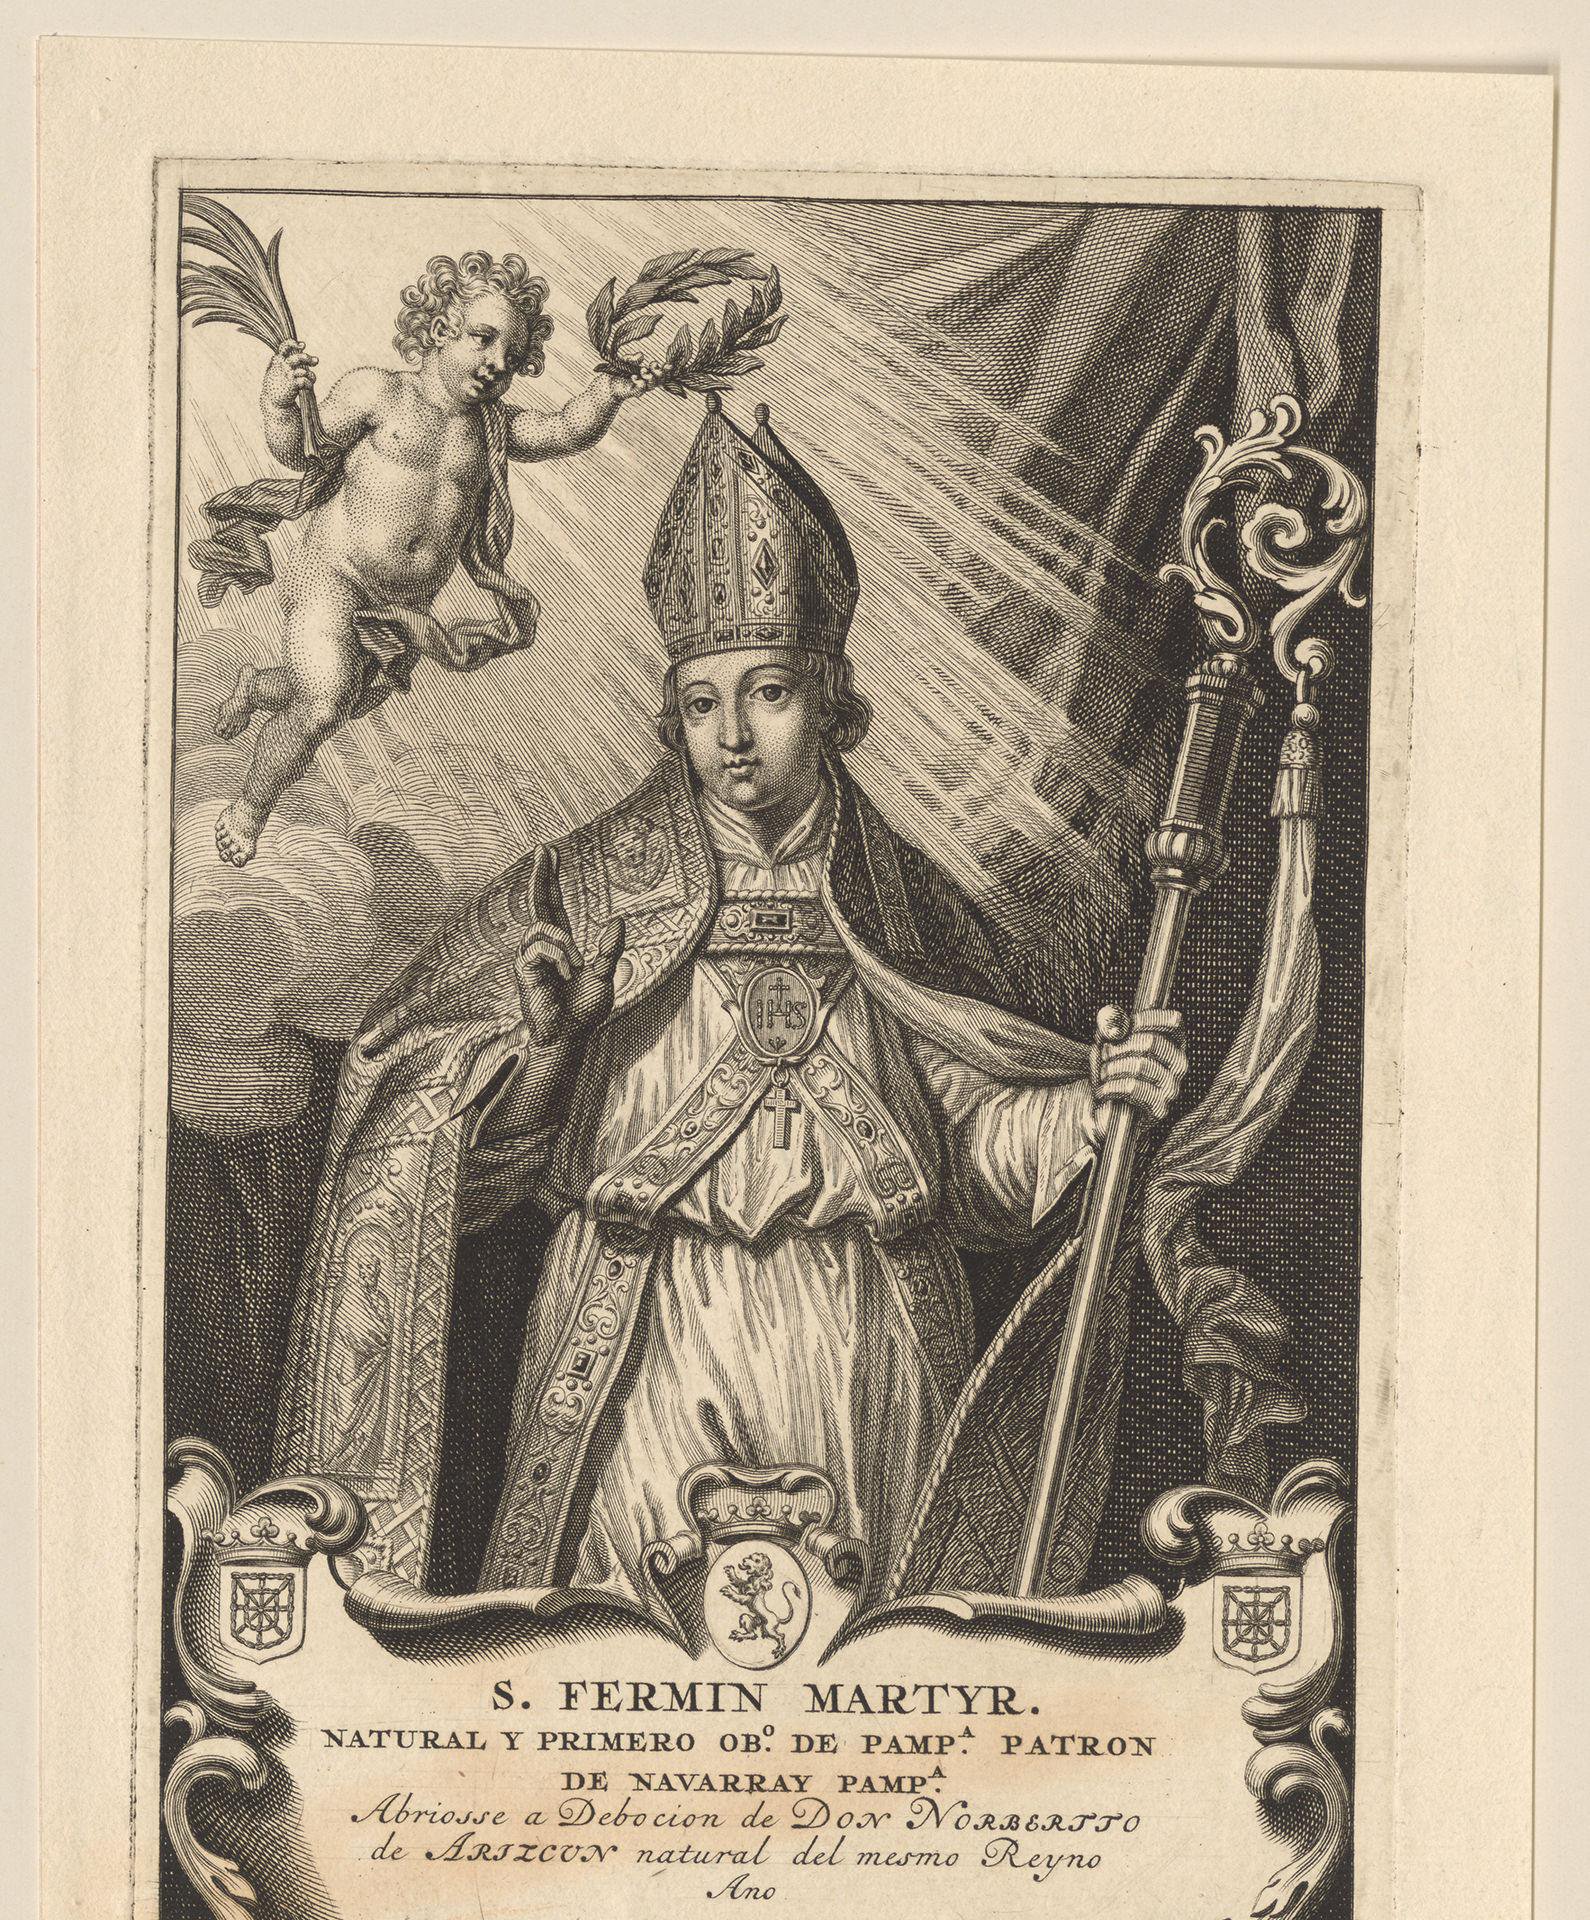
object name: print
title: Heilige Firminus de Oude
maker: bernard picart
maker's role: draughtsman, print maker, publisher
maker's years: 1673-1733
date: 1714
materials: paper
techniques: engraving, etching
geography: amsterdam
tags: archbishop, bishop, etc. (roman catholic), historical persons, male saints (with name), crowning with laurel, cupids: 'amores', 'amoretti', 'putti'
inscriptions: collector's mark: Lugt 2233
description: De Heilige Firminus de Oude, een Franse bisschop van Spaanse afkomst, maakt een zegenend gebaar. Hij wordt gelauwerd door een engel met een palmtak in de hand. In de cartouche een onderschrift in het Spaans.